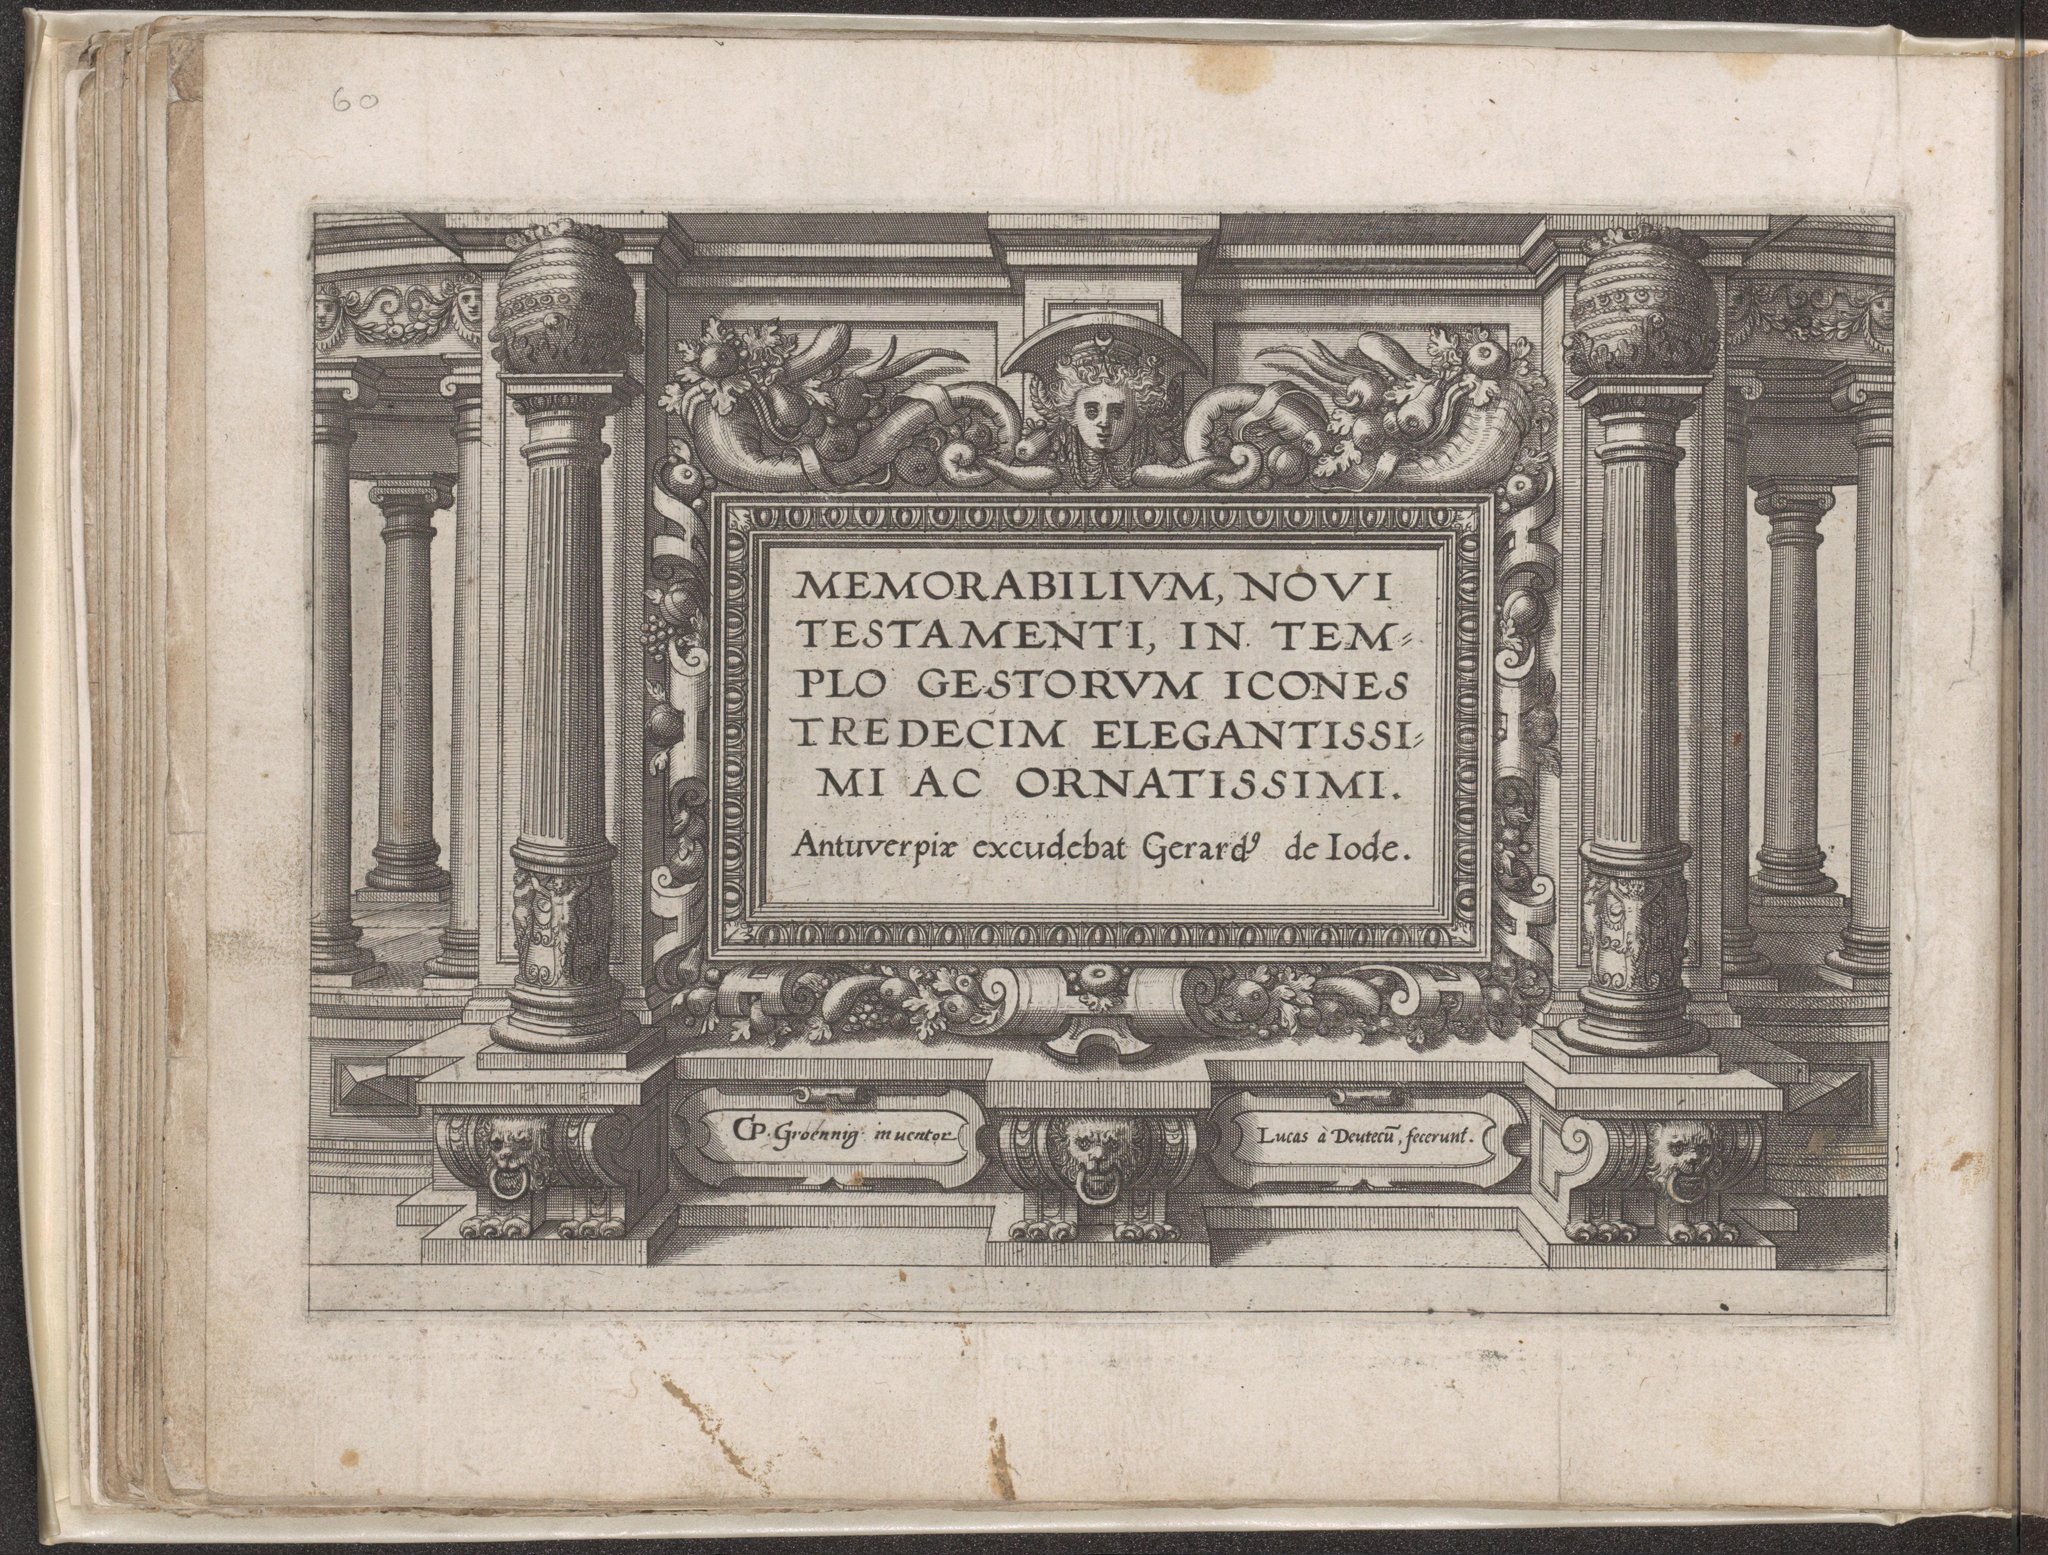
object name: print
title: Gebeurtenissen in en rond de tempel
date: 1570-1574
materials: paper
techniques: engraving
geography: antwerp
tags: ornament derived from architectural details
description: Architecturale titelprent voor een serie van 13 prenten met gebeurtenissen uit het Nieuwe Testament die zich afspelen in en rondom de tempel. Deze prent maakt deel uit van een album.